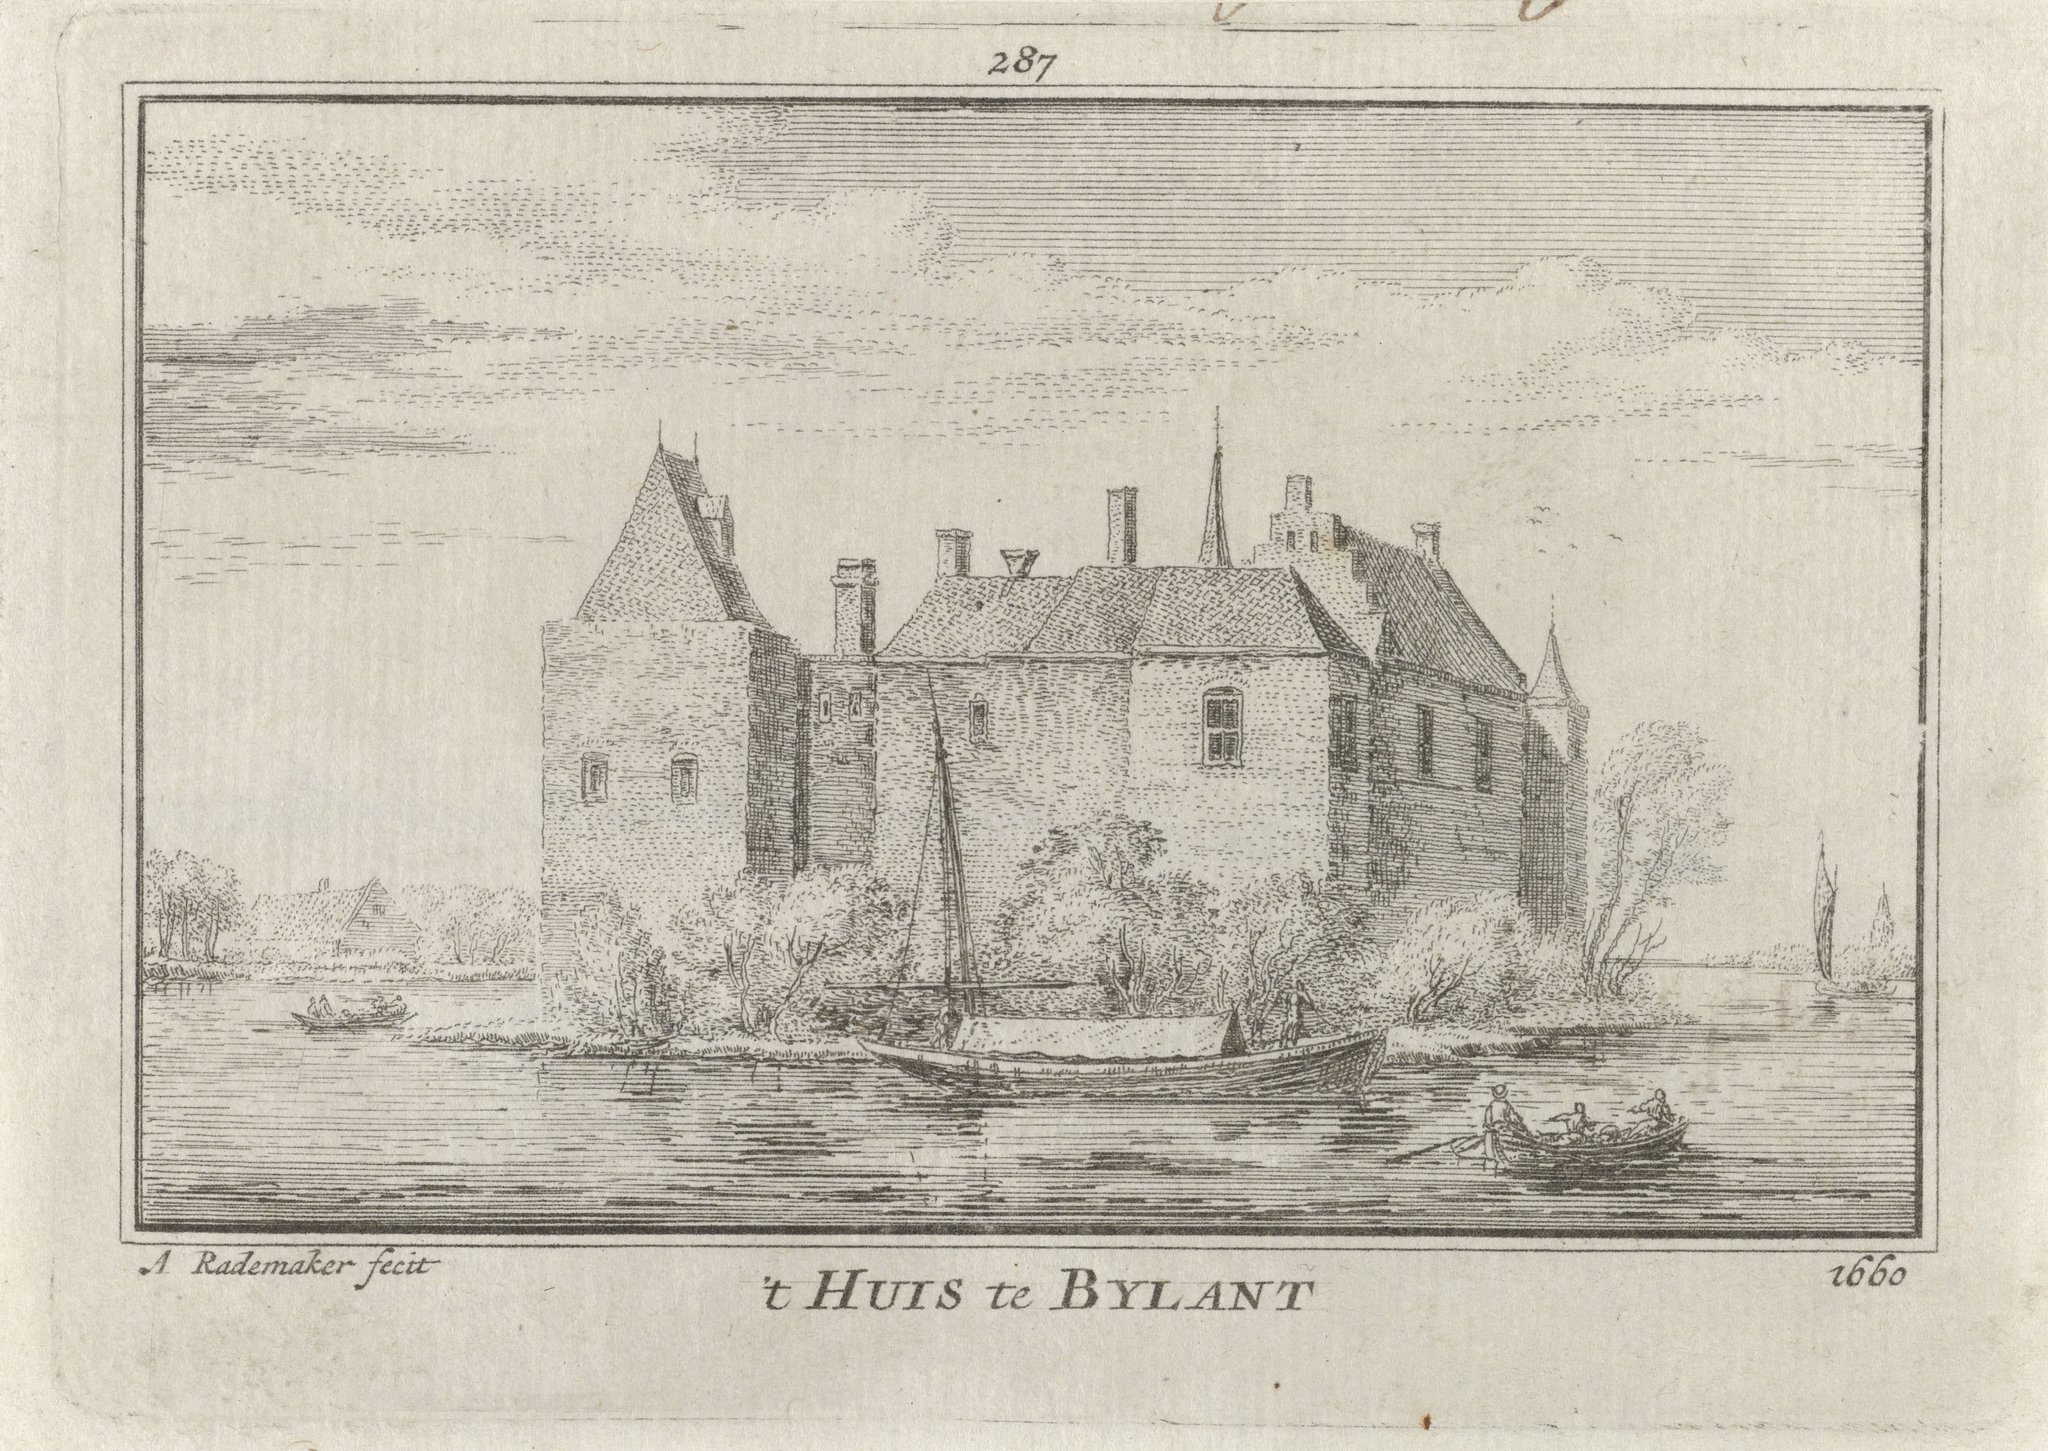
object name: book illustration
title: 't Huis te Bylant 1660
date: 1727-1733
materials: paper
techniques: etching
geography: amsterdam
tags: waal, kasteel bylandt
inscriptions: collector's mark: Lugt 2228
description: Illustratie uit: Abraham Rademaker, Matthaeus Brouërius van Niedek, Isaac Le Long, Kabinet van Nederlandsche en Kleefsche outheden en (...) voorname stads- en landgebouwen, Willem Barents en Antoni Schoonenburg: Amsterdam, 1727-1733, ill. nr. 287.